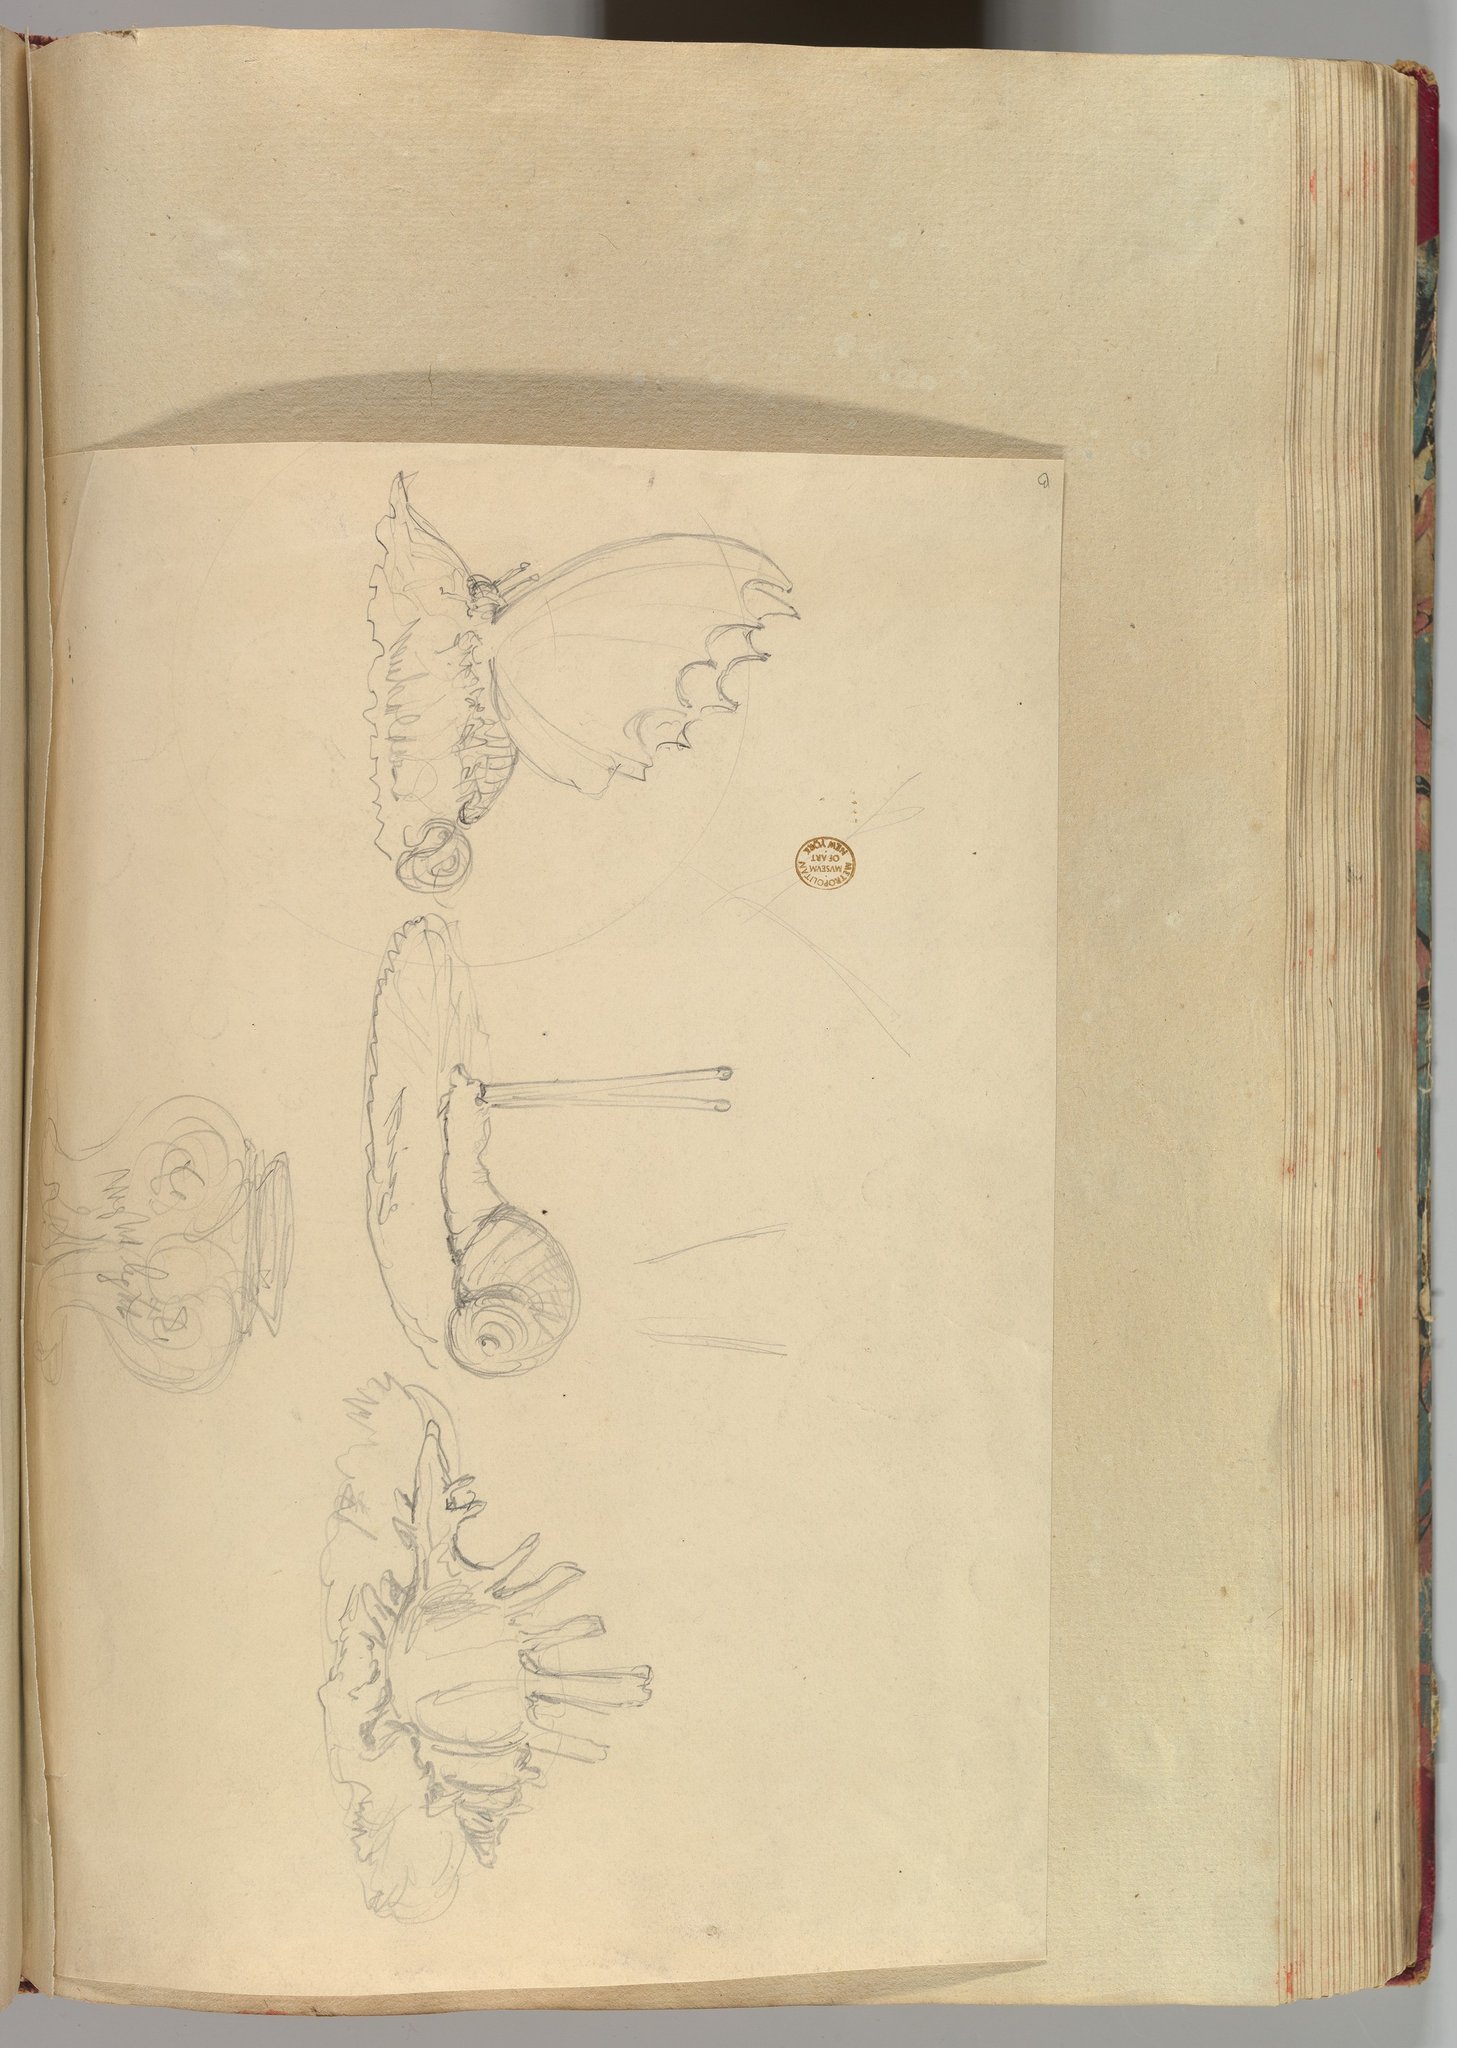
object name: drawing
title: Sketches of Butterfly Pen-holder, a Shell Pen-holder and Snail Ring-holder, and a Vase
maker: alfred henry forrester [alfred crowquill]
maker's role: artist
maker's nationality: british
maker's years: 1804-1872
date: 1845-1855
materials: graphite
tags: butterflies,snails,shells